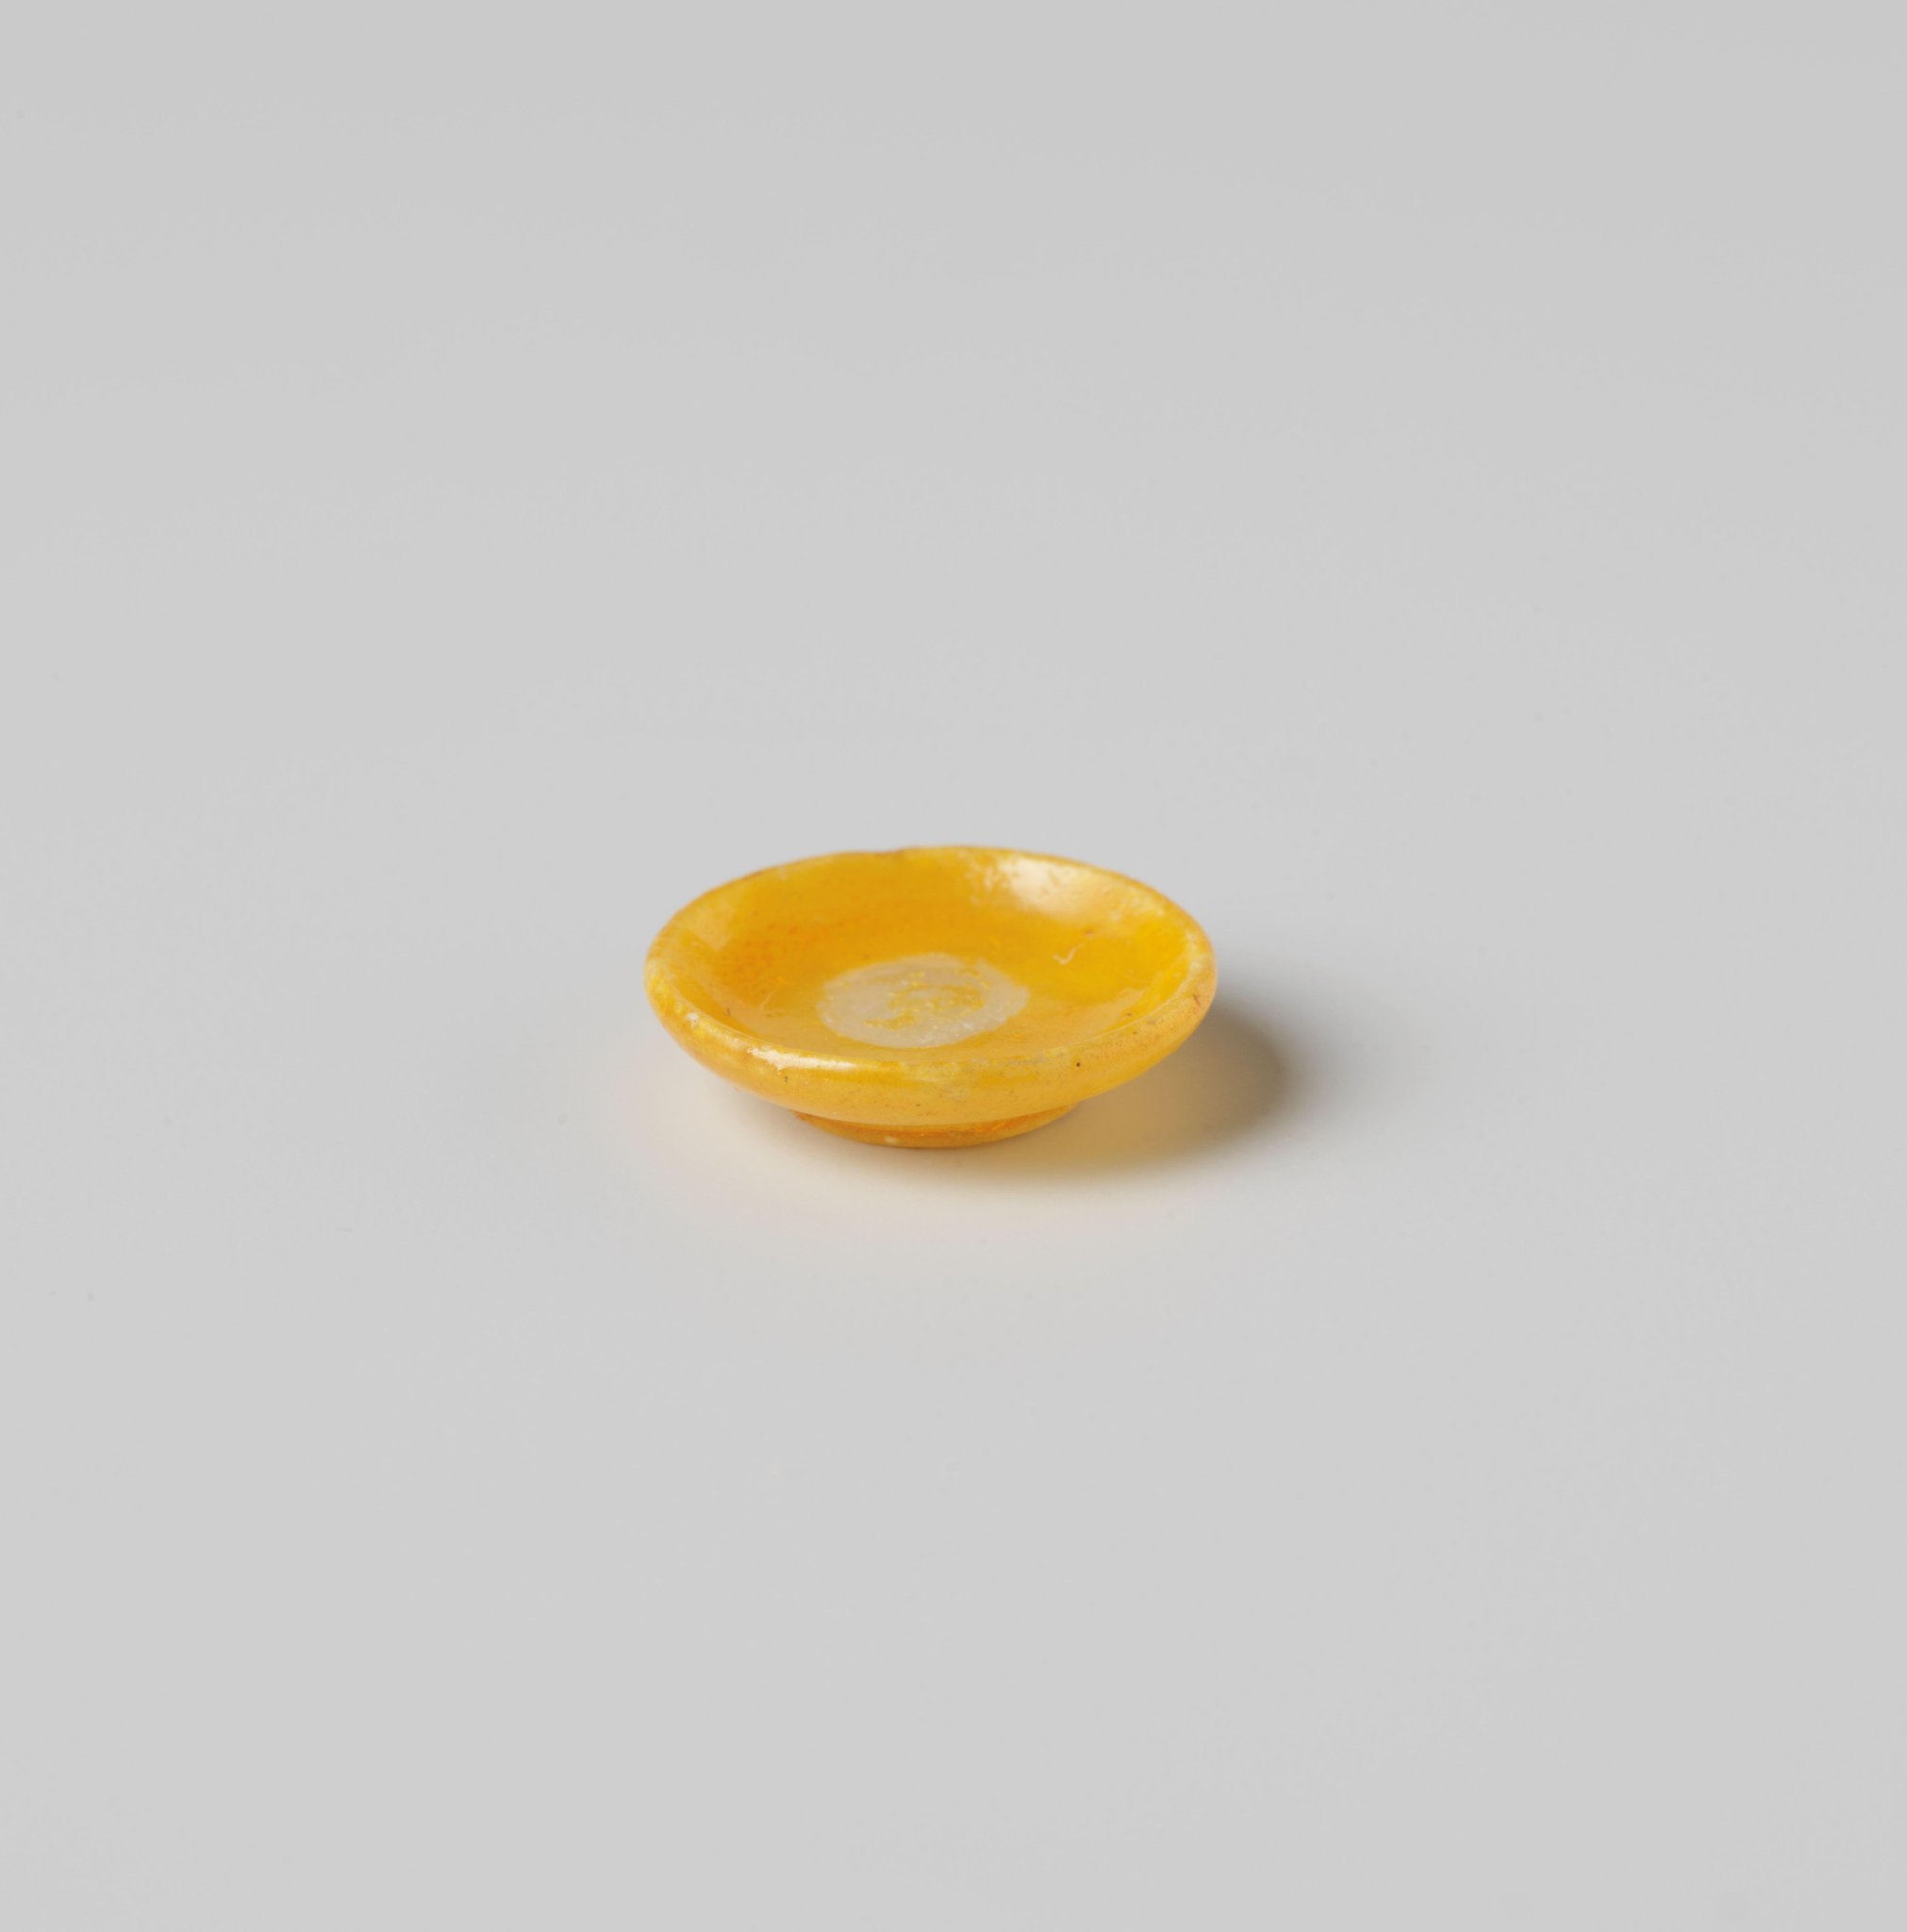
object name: platter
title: Schotel, geelgelakt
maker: Anonymous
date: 1750-1800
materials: alabaster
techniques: lacquer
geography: germany